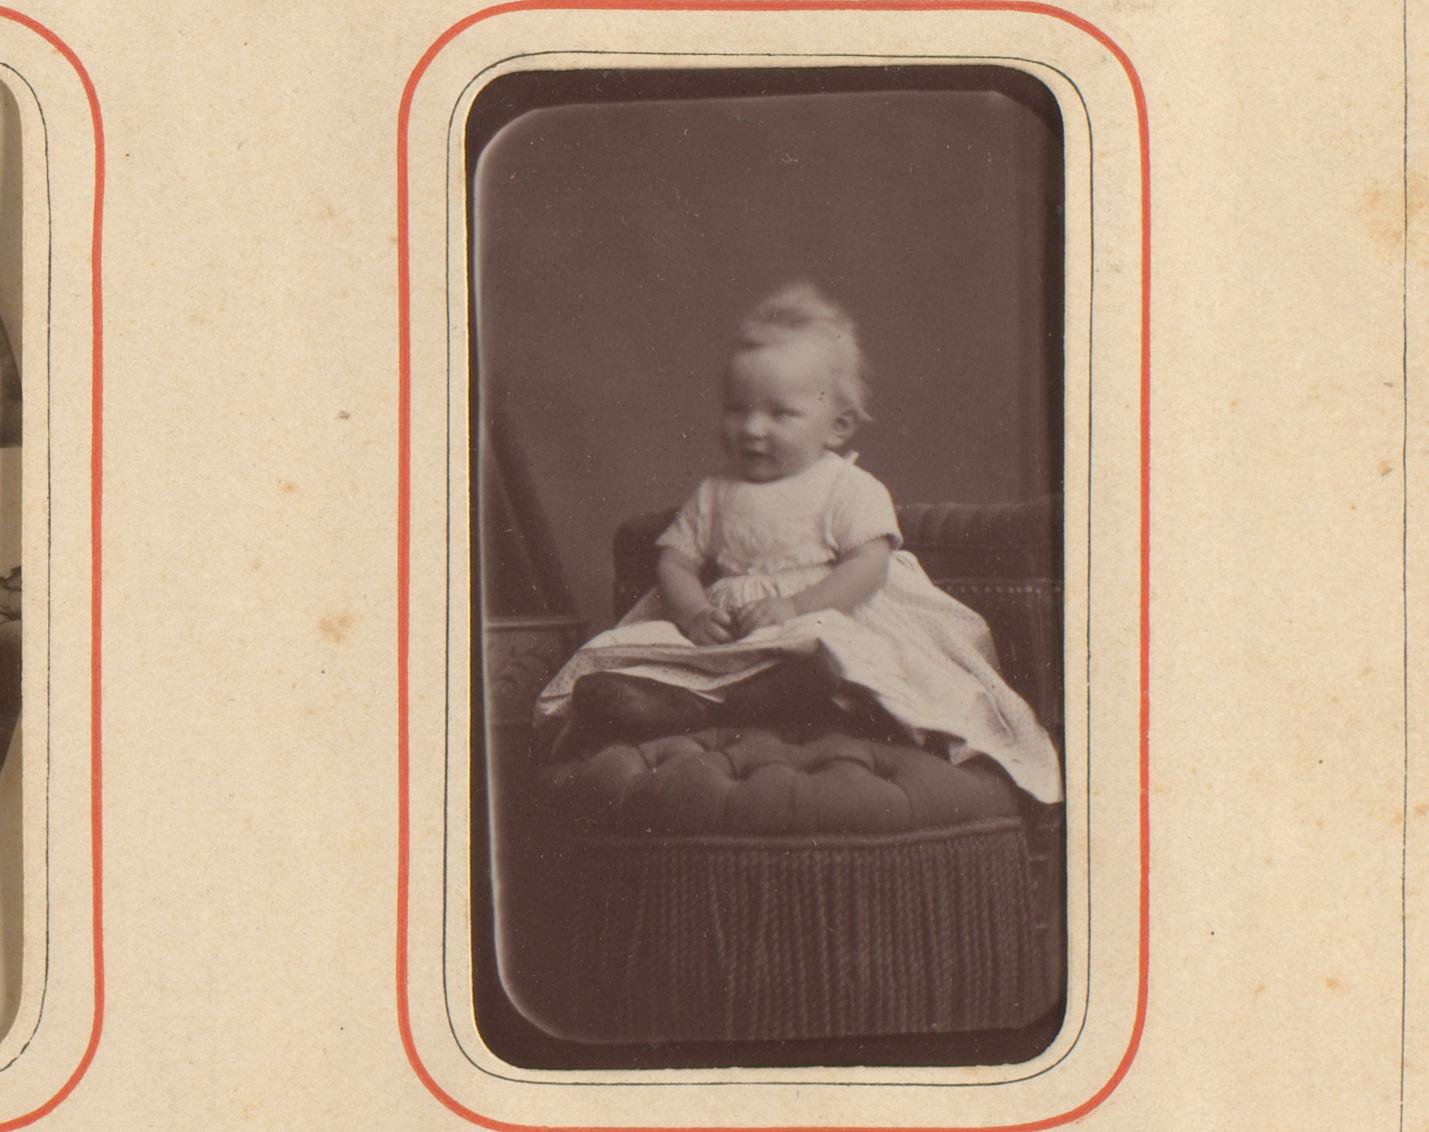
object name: carte de visite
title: Fotoreproductie van een fotoportret van een onbekend kind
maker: albert greiner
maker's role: fotograaf, fotostudio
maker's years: 1833-1890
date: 1874-1887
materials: cardboard, paper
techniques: carbon print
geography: amsterdam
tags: anonymous historical person portrayed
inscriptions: address: ‘Nieuwendyk L. 89./ AMSTERDAM.’, inscription: ‘Onveranderlyke Kooldruk’